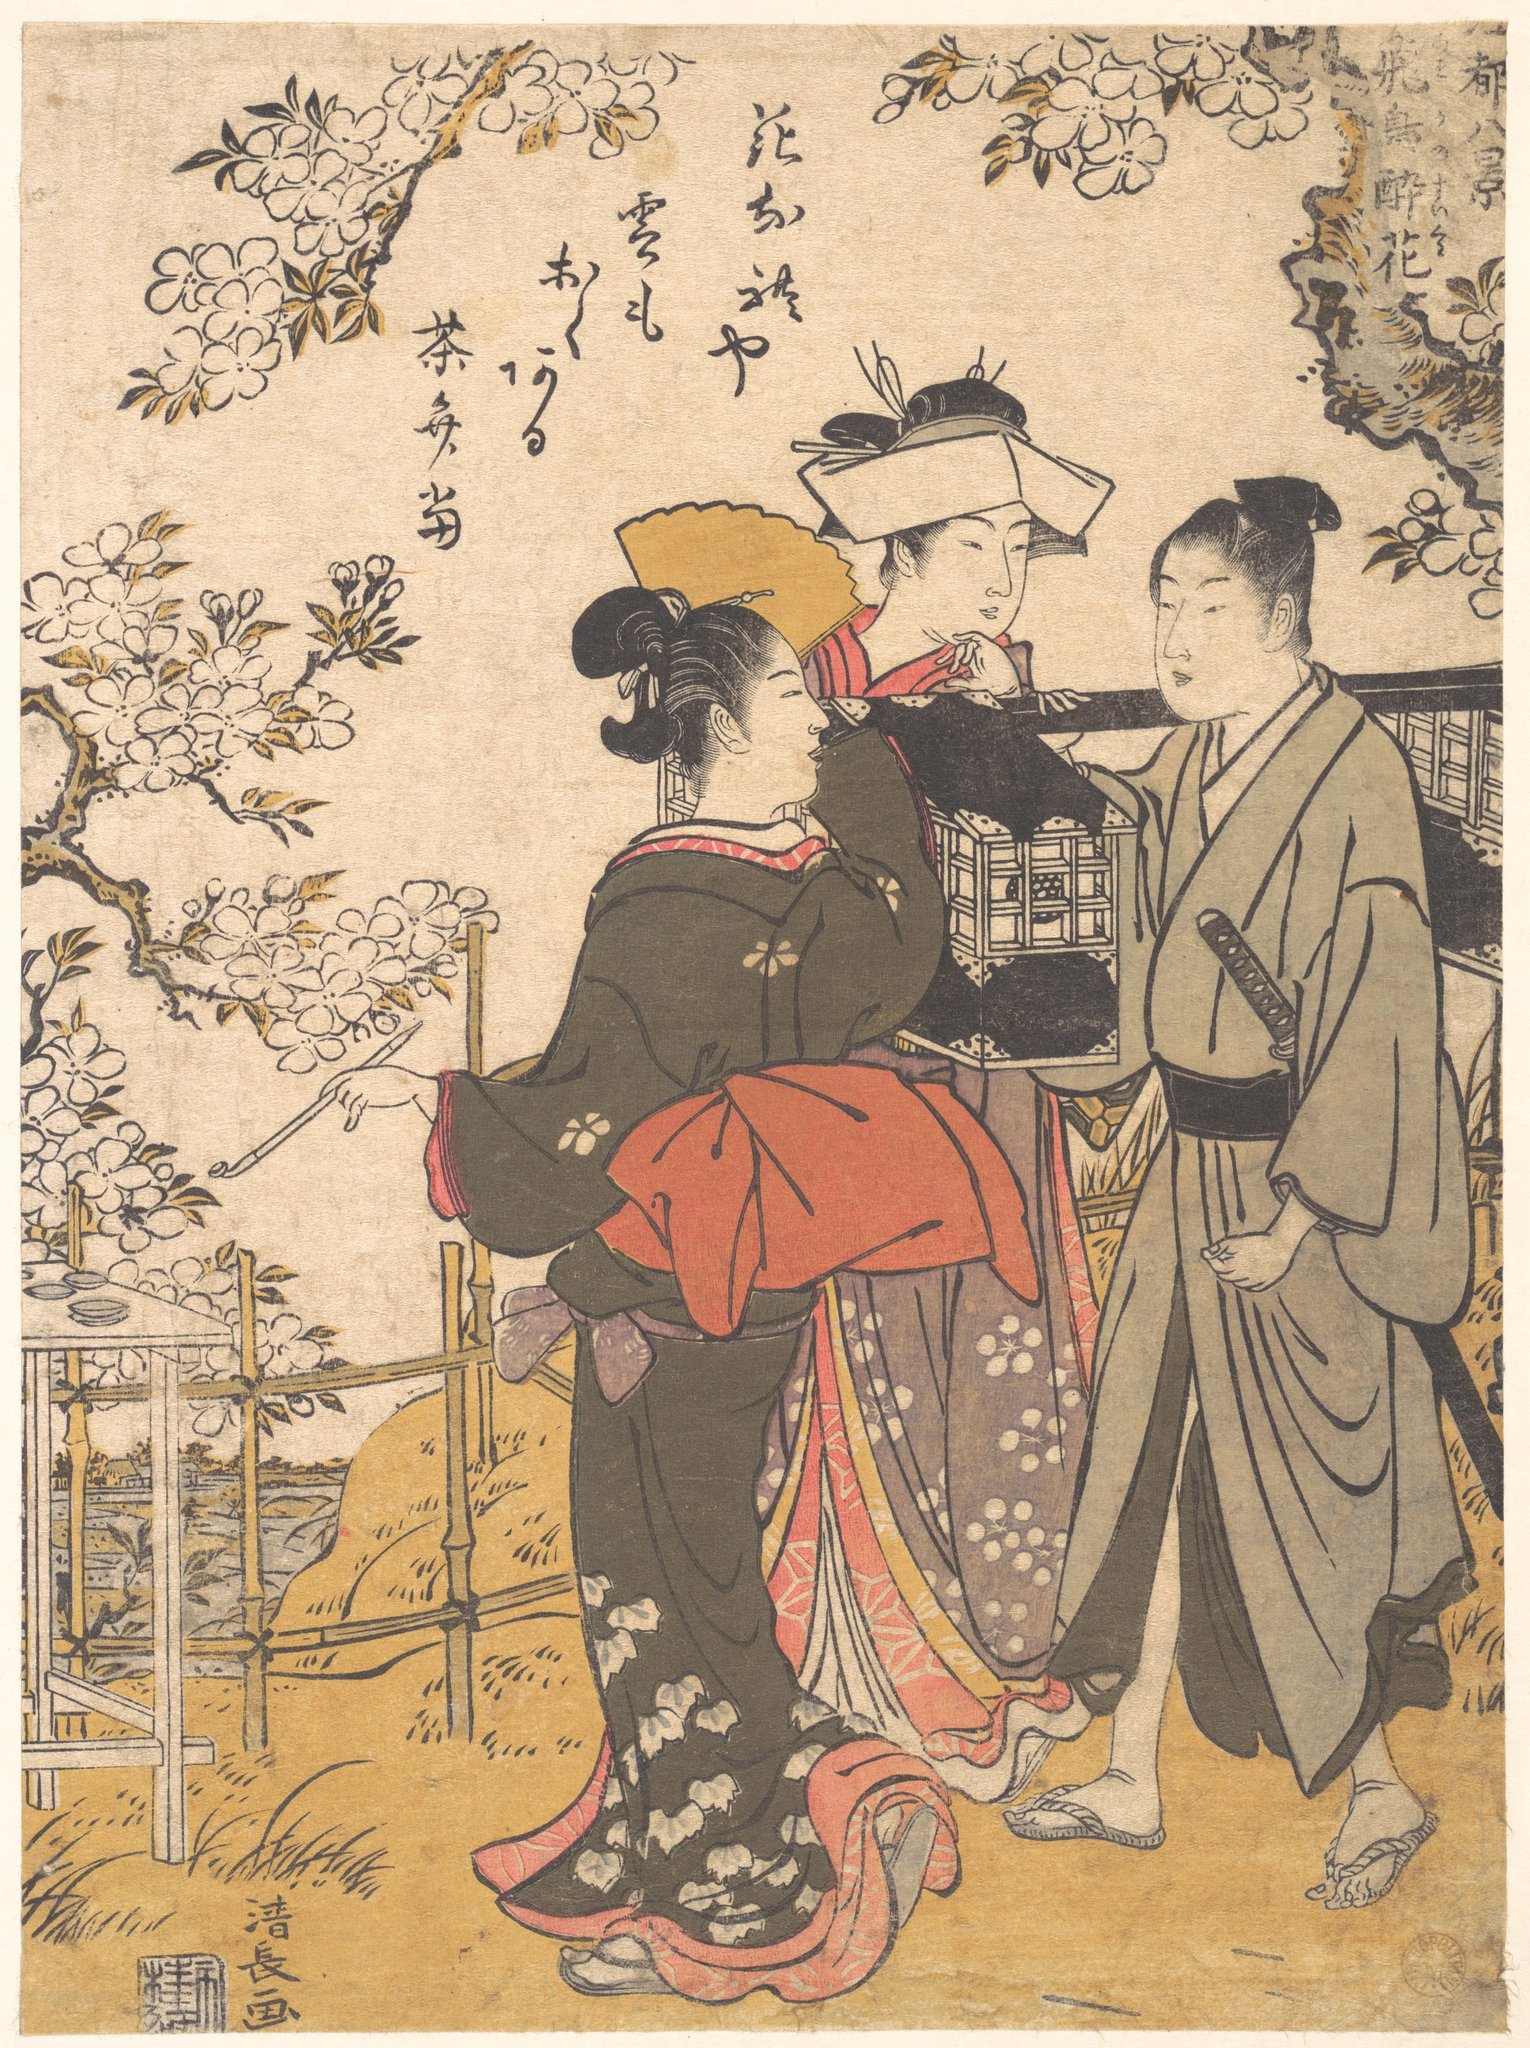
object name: print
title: Drunk with Flowers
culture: japanese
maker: torii kiyonaga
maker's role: artist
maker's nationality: japanese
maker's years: 1752-1815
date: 1781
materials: ink, paper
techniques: woodblock print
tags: women,flowers